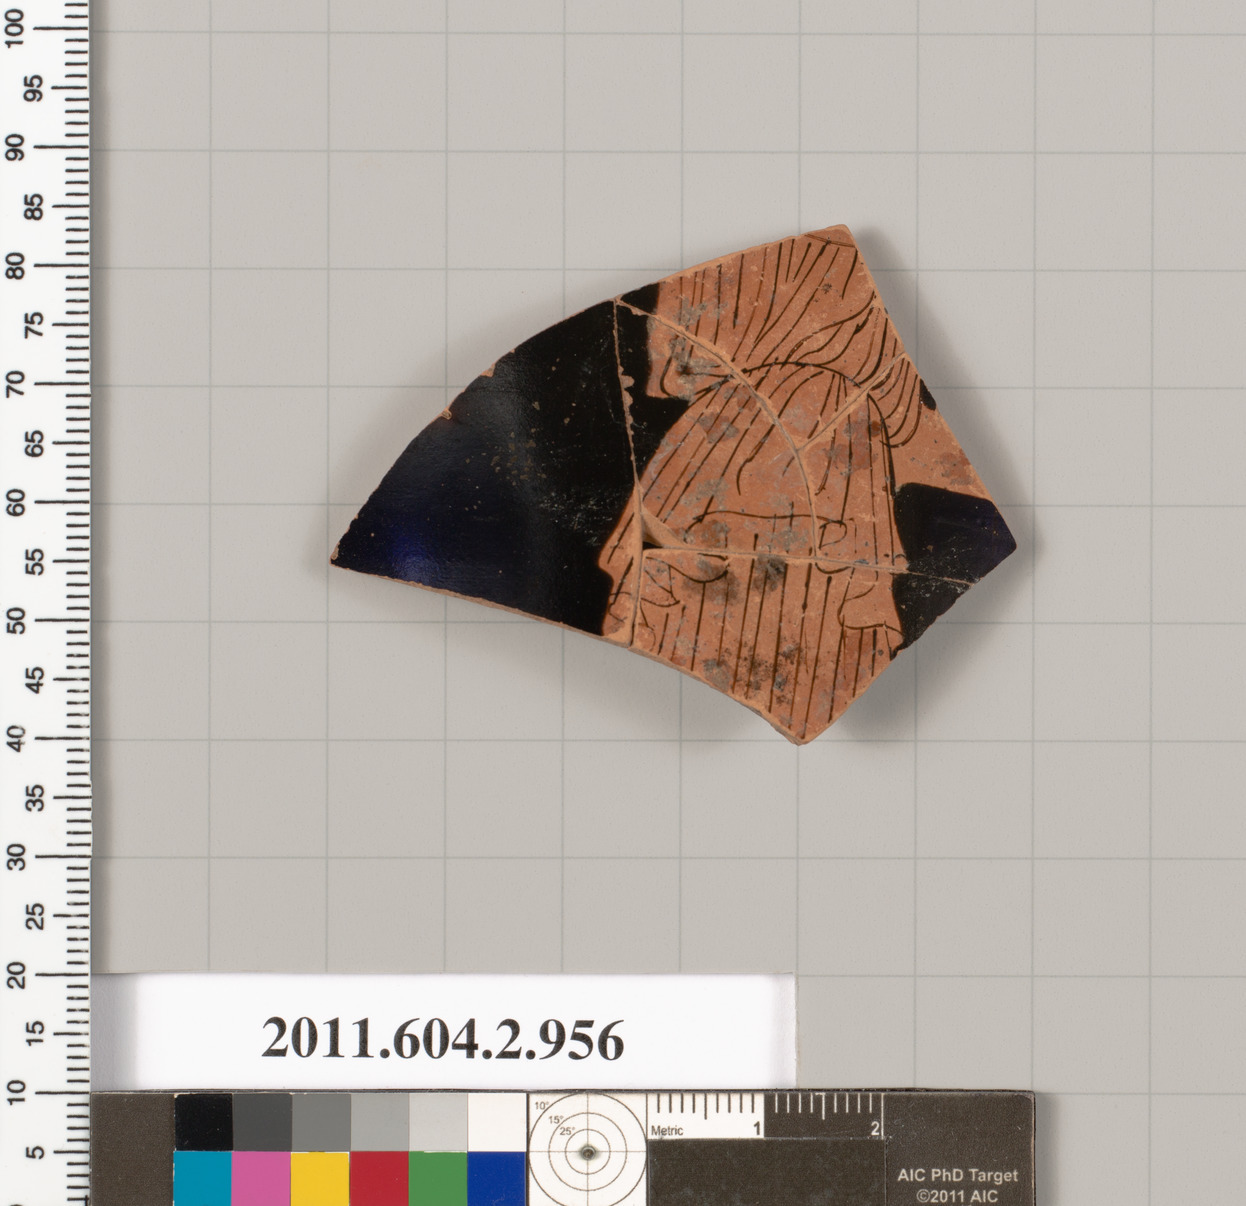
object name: oinochoe fragment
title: Terracotta fragment of an oinochoe (jug)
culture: greek, attic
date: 475-451 BCE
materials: terracotta